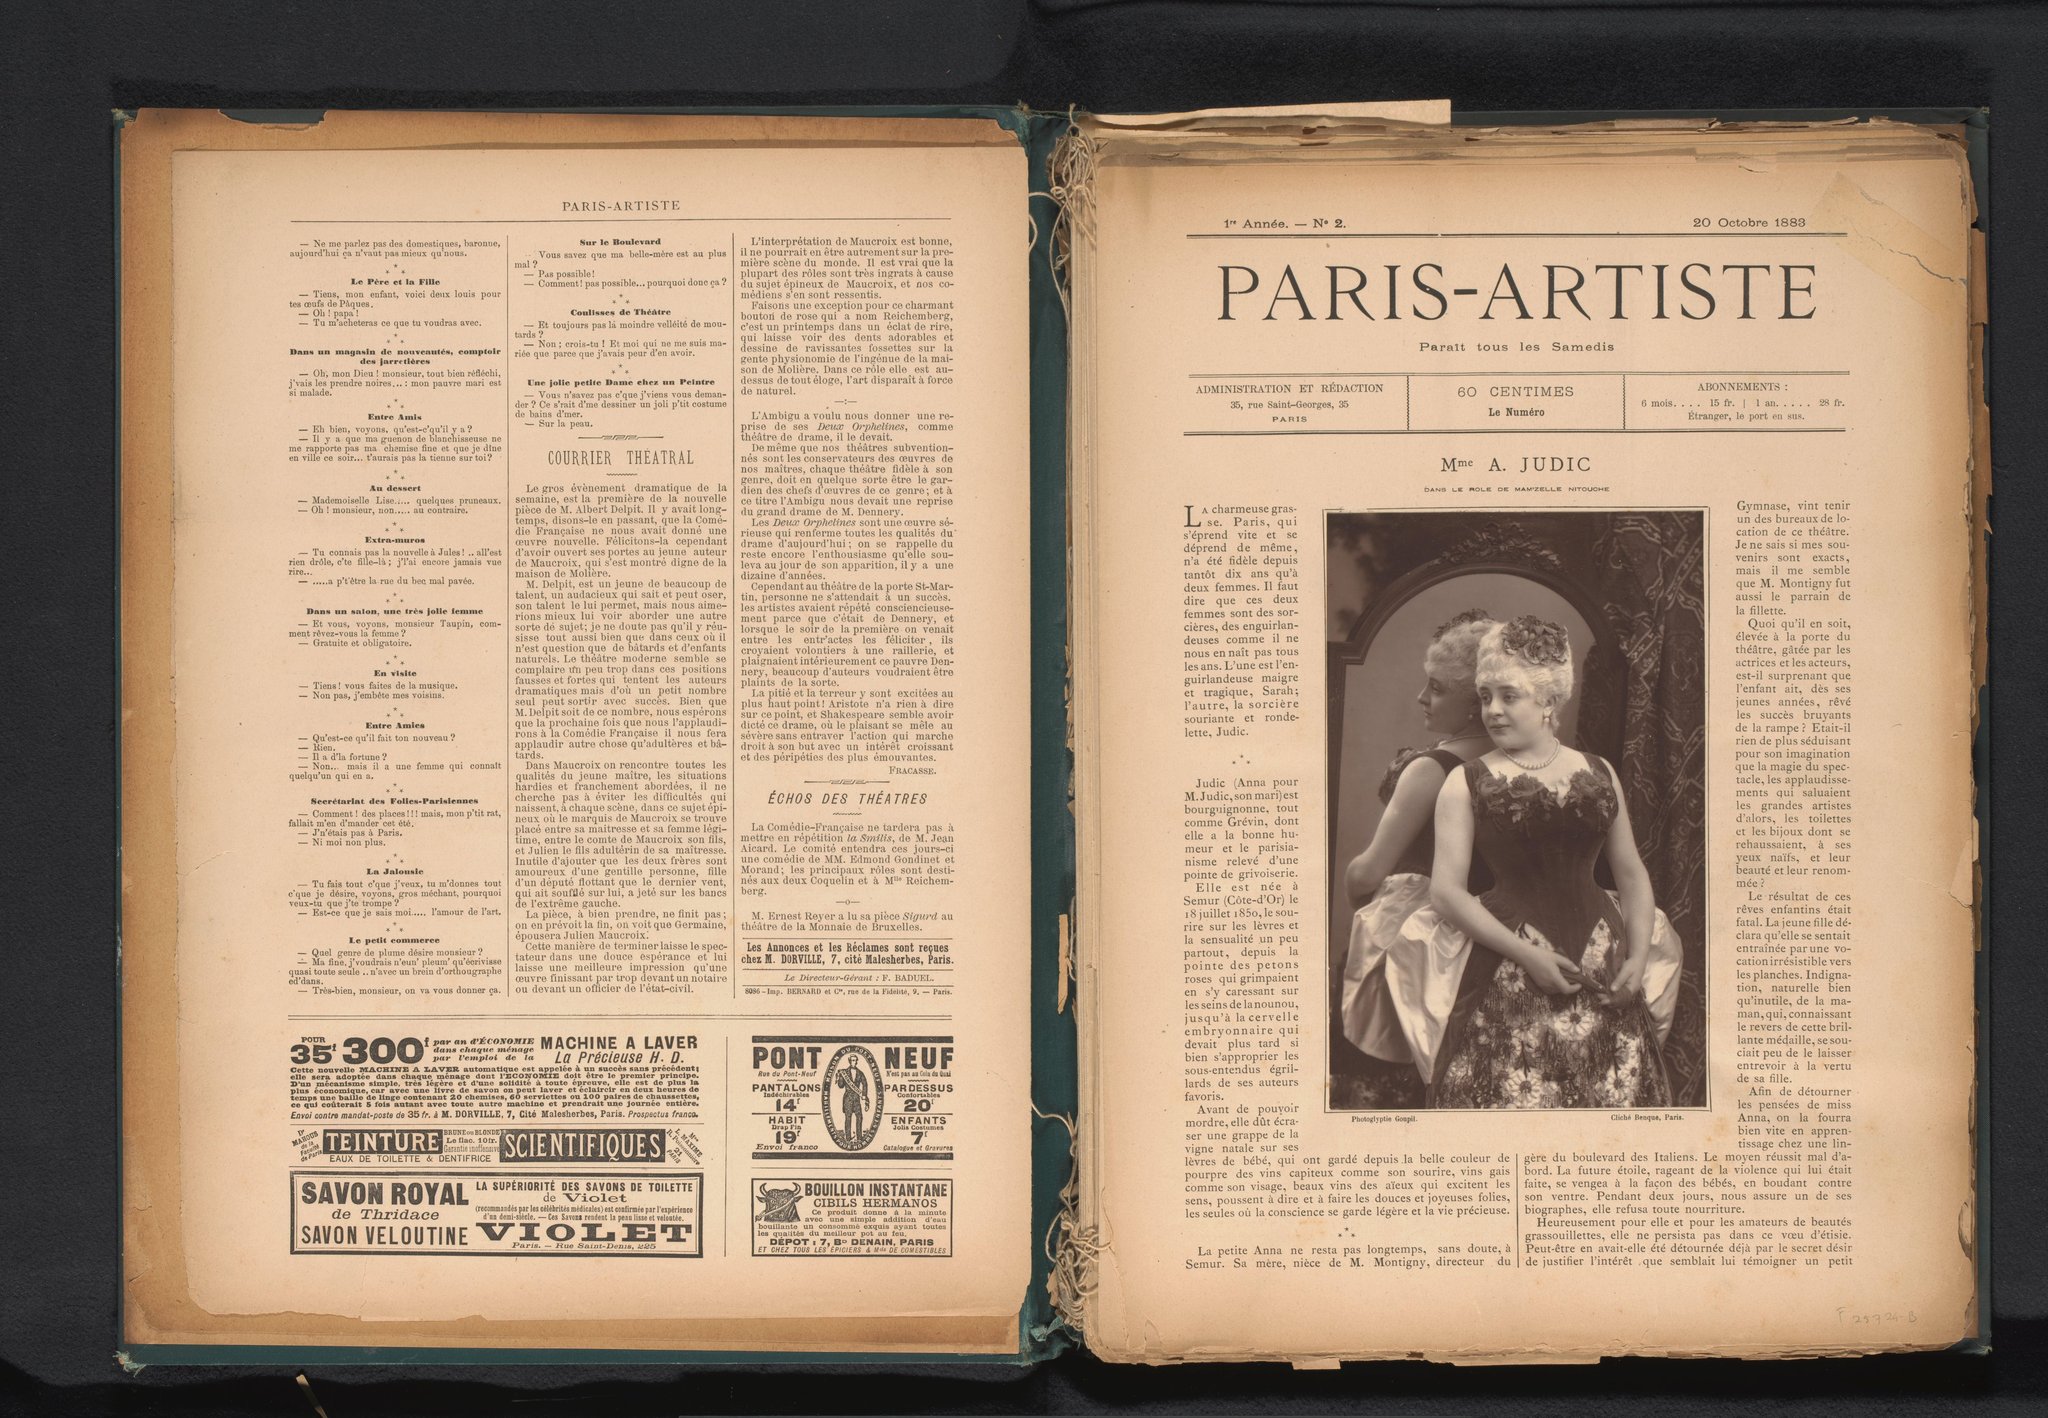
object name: photomechanical print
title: Portret van Anna Judic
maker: wilhelm benque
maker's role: fotograaf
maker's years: 1843-1903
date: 1878-1883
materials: paper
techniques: woodburytype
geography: paris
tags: historical persons - bb - woman, portrait of actor, actress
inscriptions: inscription: ‘Dans le role de mam'zelle nitouche’